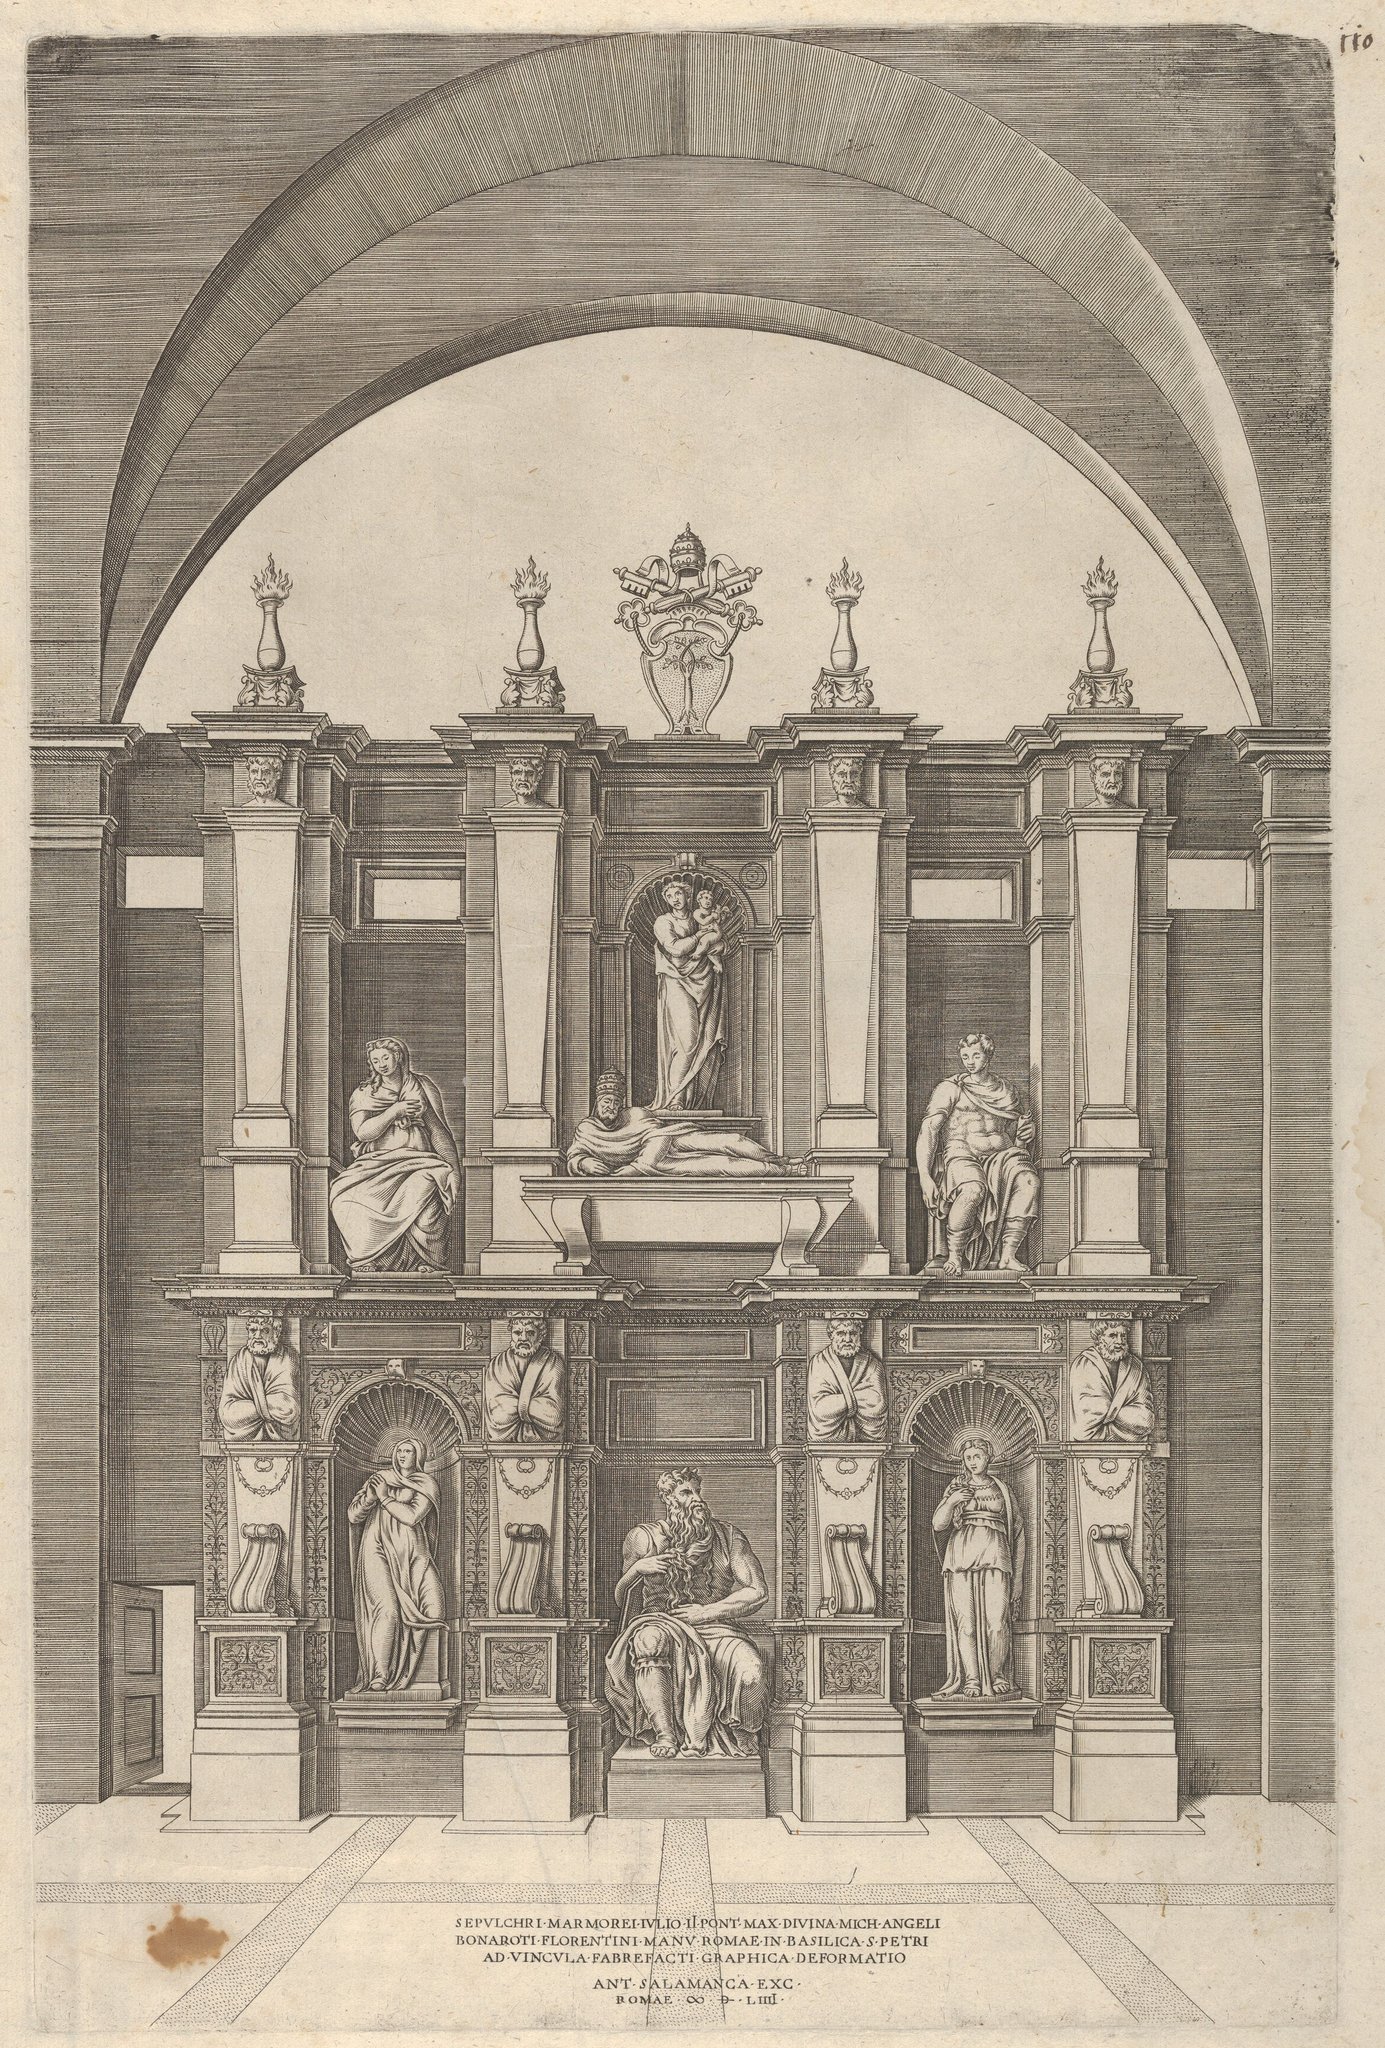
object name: print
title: Sepulchre of Julius II, from "Speculum Romanae Magnificentiae"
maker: Anonymous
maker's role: artist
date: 1554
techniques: engraving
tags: architecture,tombs,rome